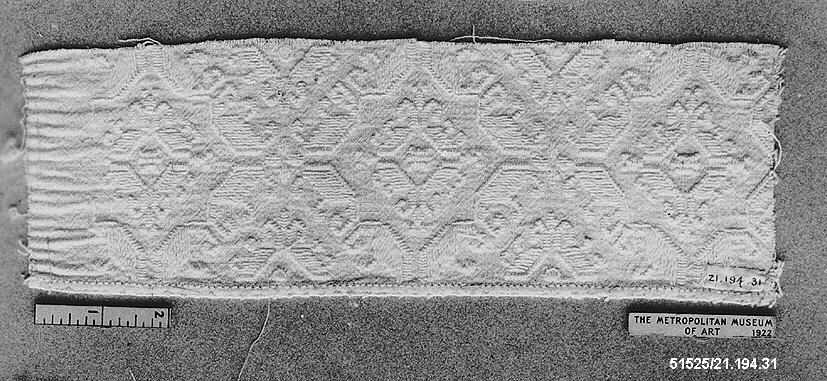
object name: strip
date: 1801-1900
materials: cotton